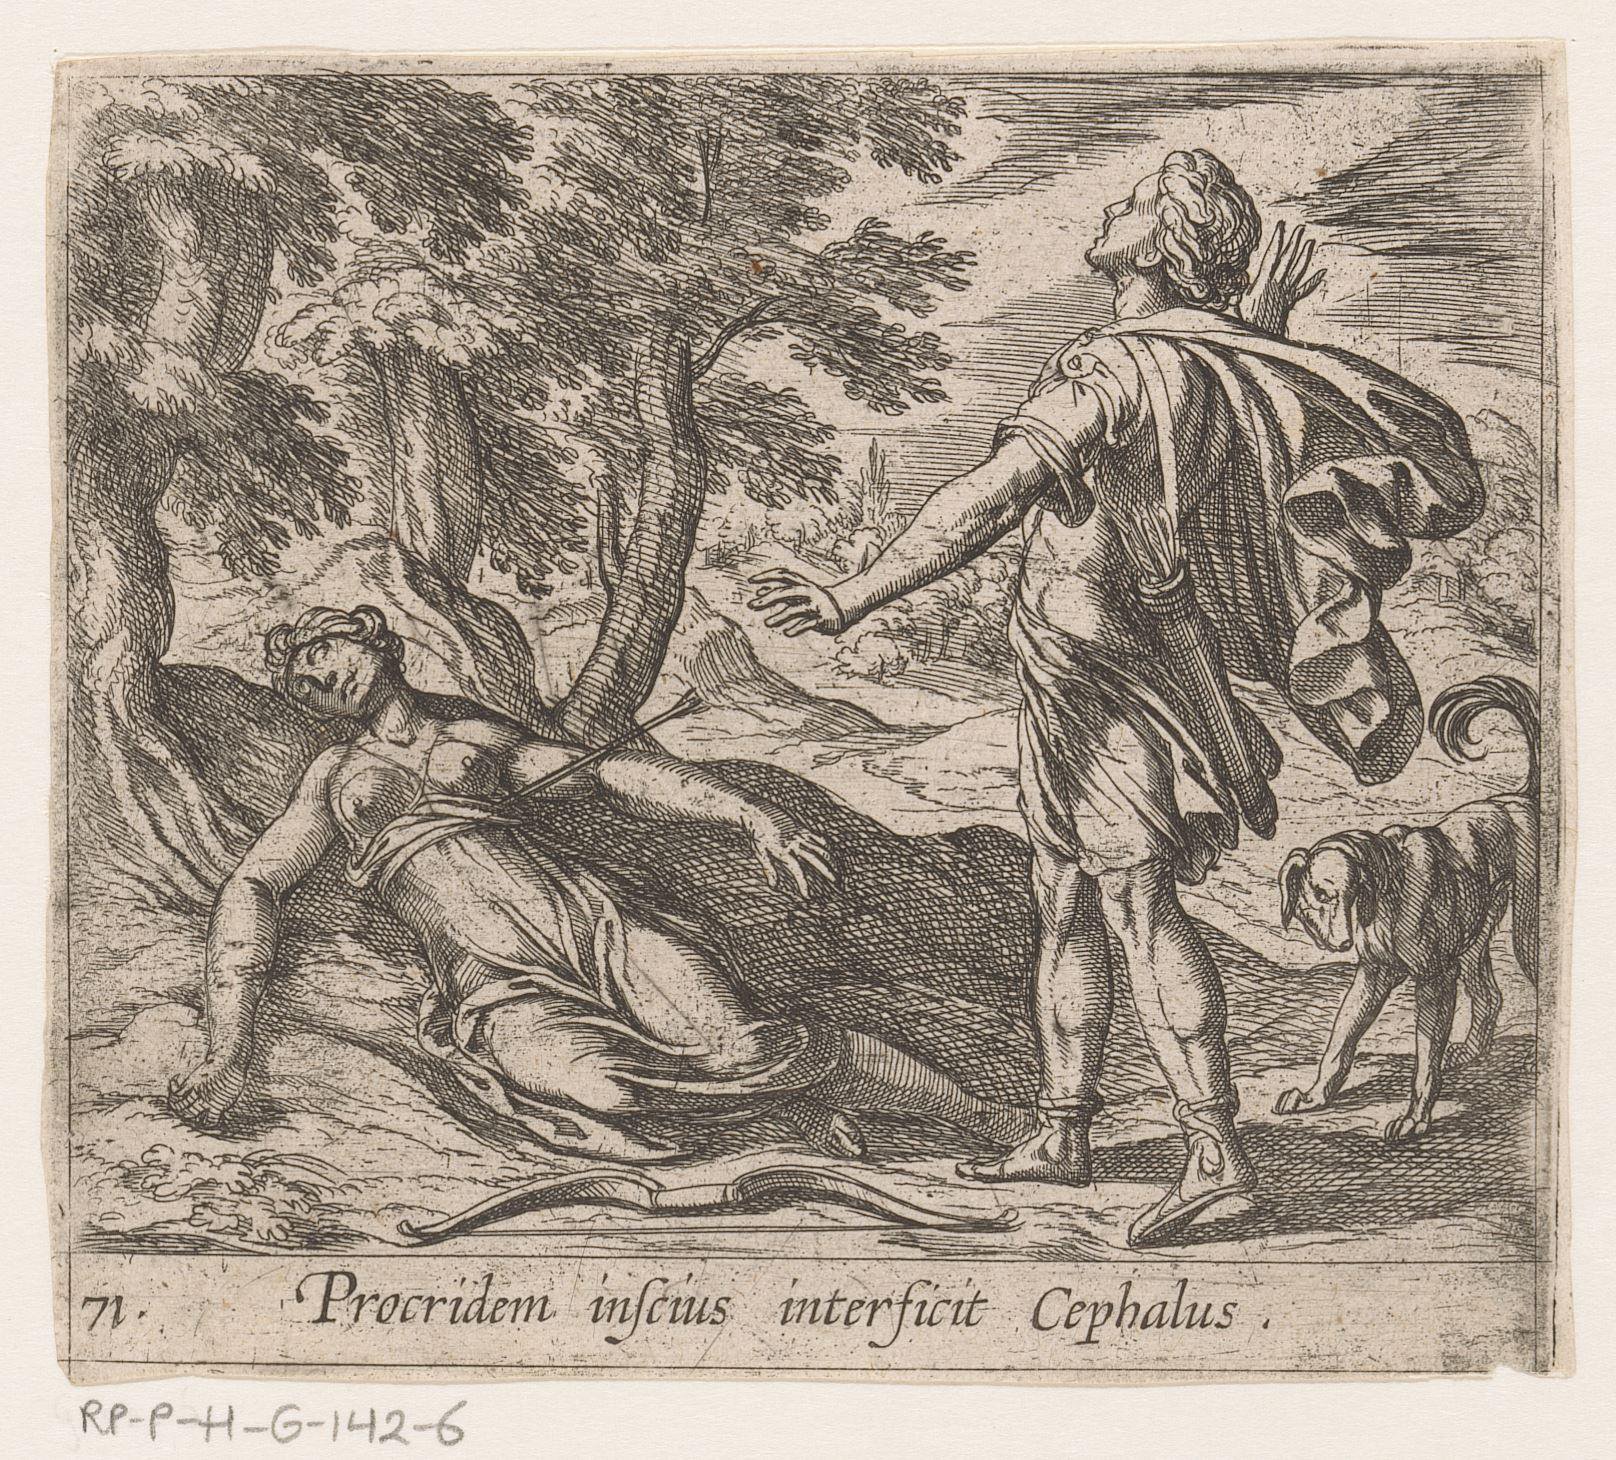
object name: print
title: Metamorfosen van Ovidius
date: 1606-1638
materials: paper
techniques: etching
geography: amsterdam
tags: cephalus inadvertently kills procris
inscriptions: collector's mark: ‘Hinloopen’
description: Deze prent maakt deel uit van een reeks van 150 prenten (+ titelprent) met voorstellingen van de Metamorfosen van Ovidius.